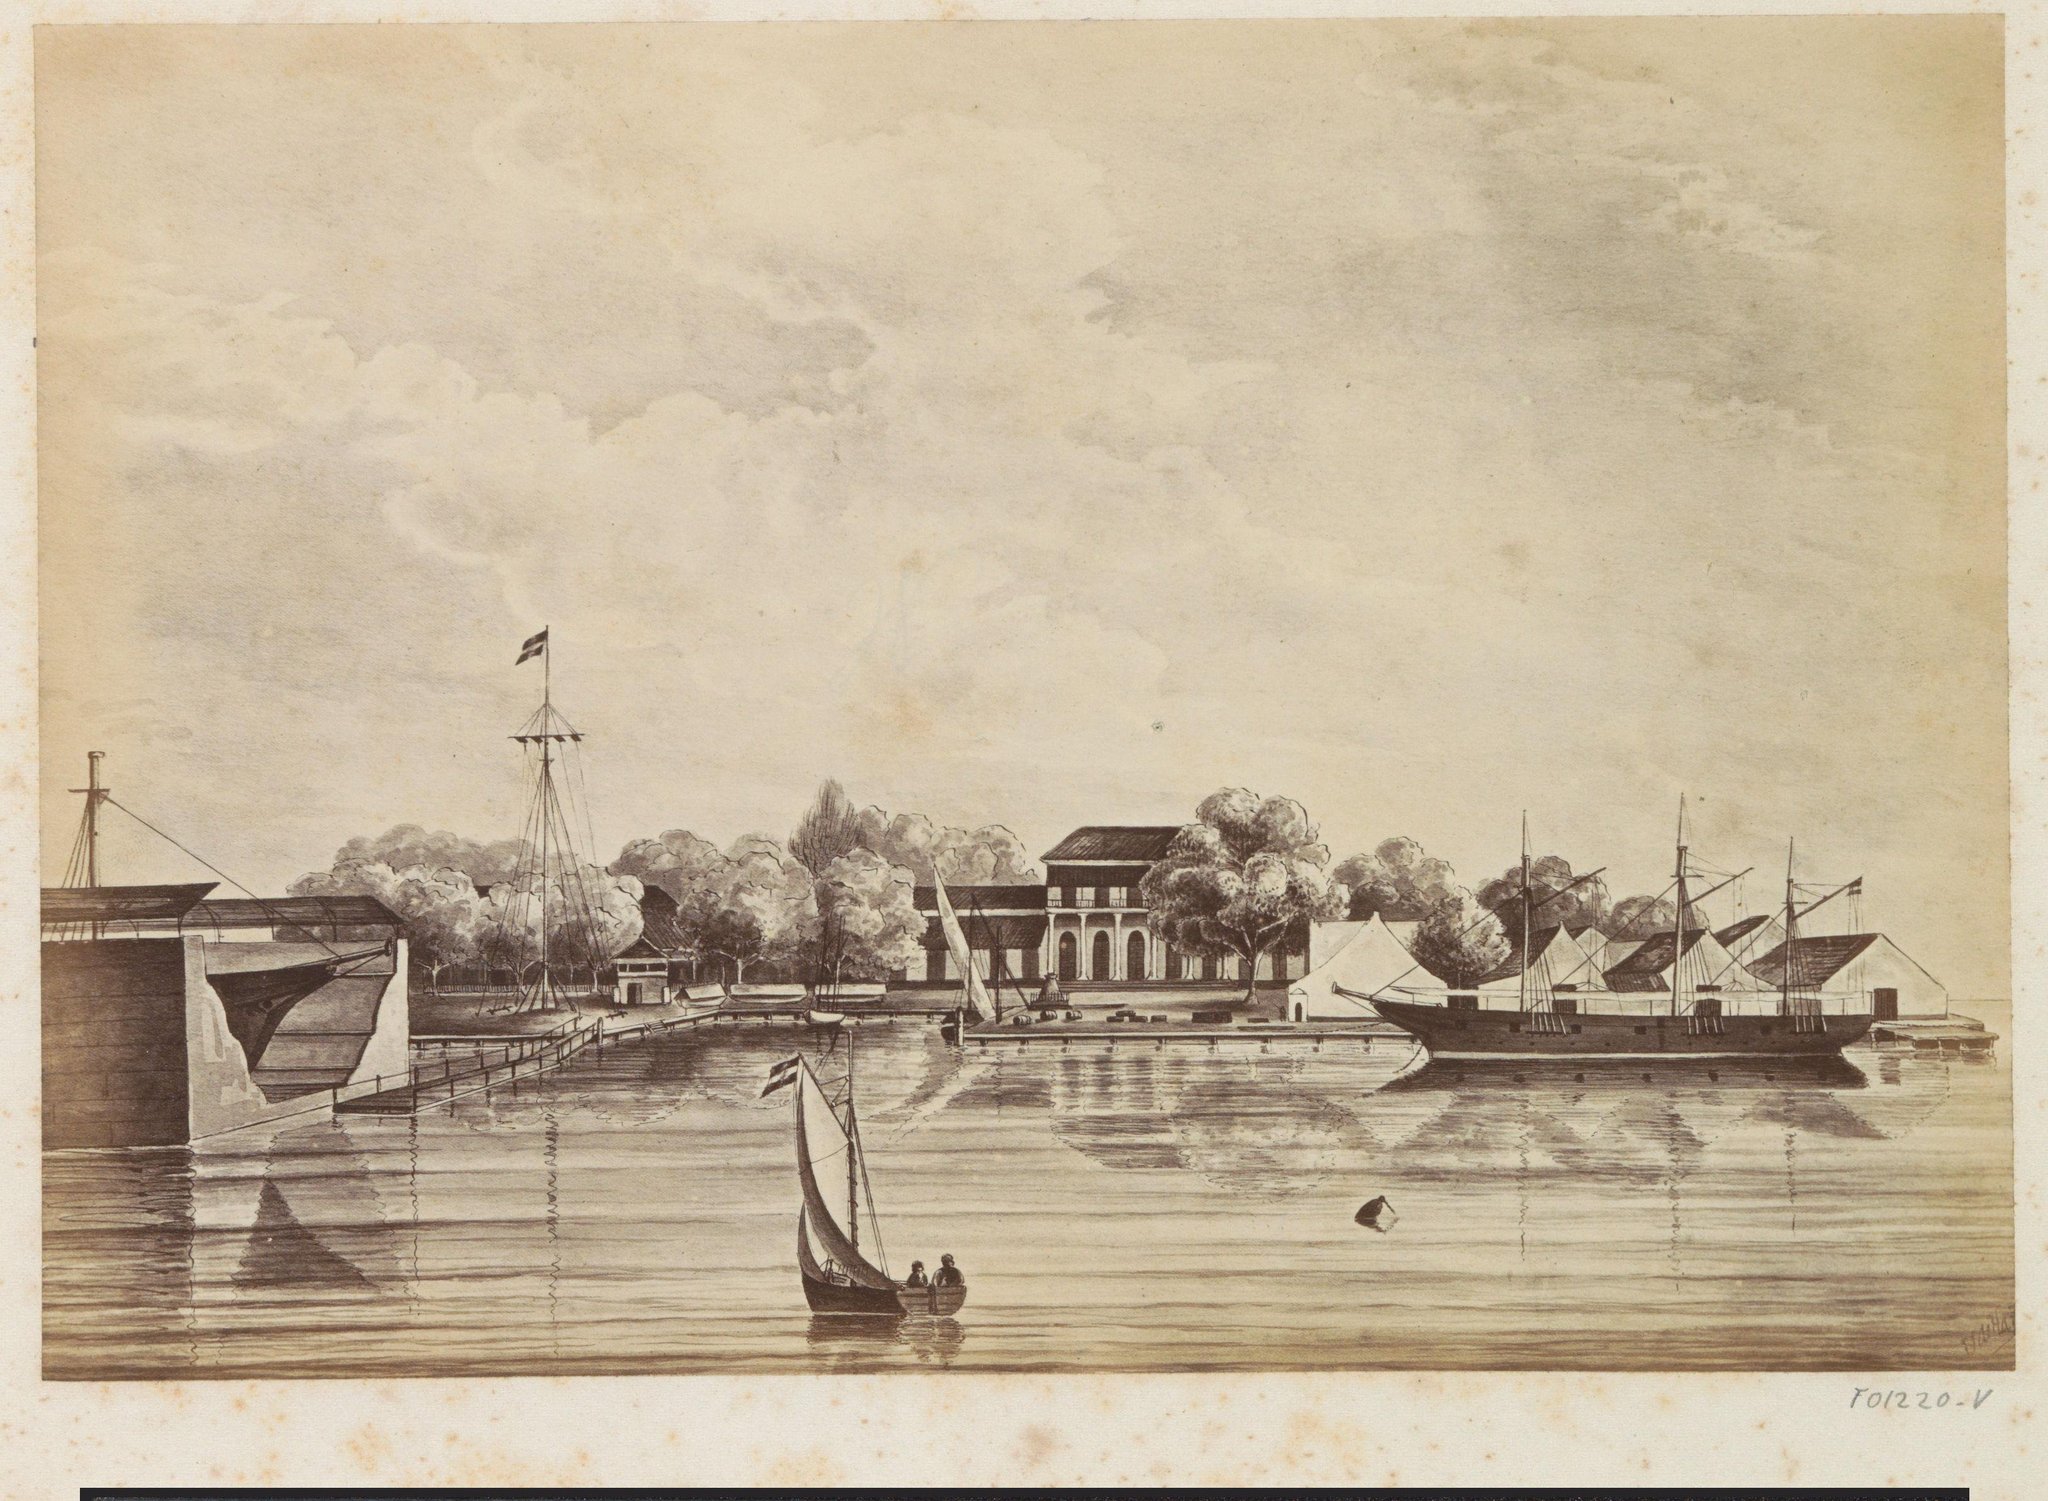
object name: photograph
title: Fotoreproductie van (vermoedelijk) een tekening, voorstellend een havengezicht met dok op Java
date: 1857-1870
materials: photographic support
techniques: albumen print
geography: java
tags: harbour (+ view ~ vehicle, ship, etc.), dry-dock, floating-dock, java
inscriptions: signature: ‘[...]de Ha[...]’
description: Onderdeel van Fotoalbum met opnames van bezienswaardigheden op Java.